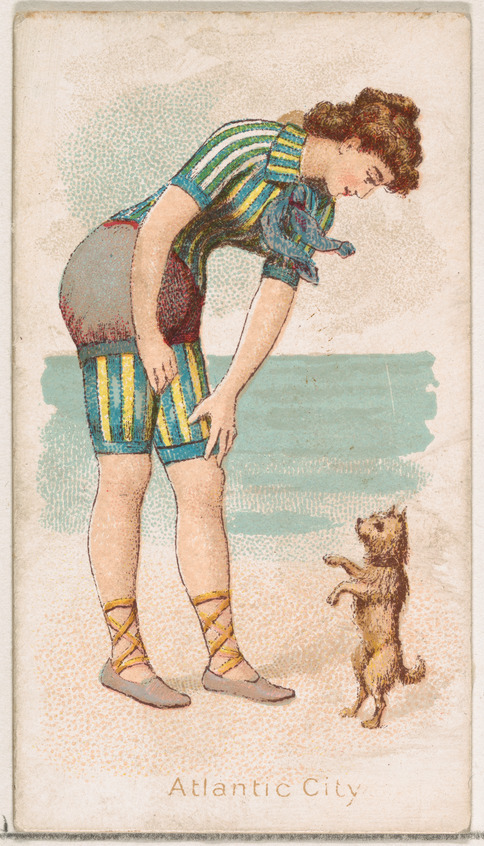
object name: print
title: Atlantic City, from the Fancy Bathers series (N187) issued by Wm. S. Kimball & Co.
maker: william s. kimball & company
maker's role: publisher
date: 1889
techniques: color lithograph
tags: women,dogs